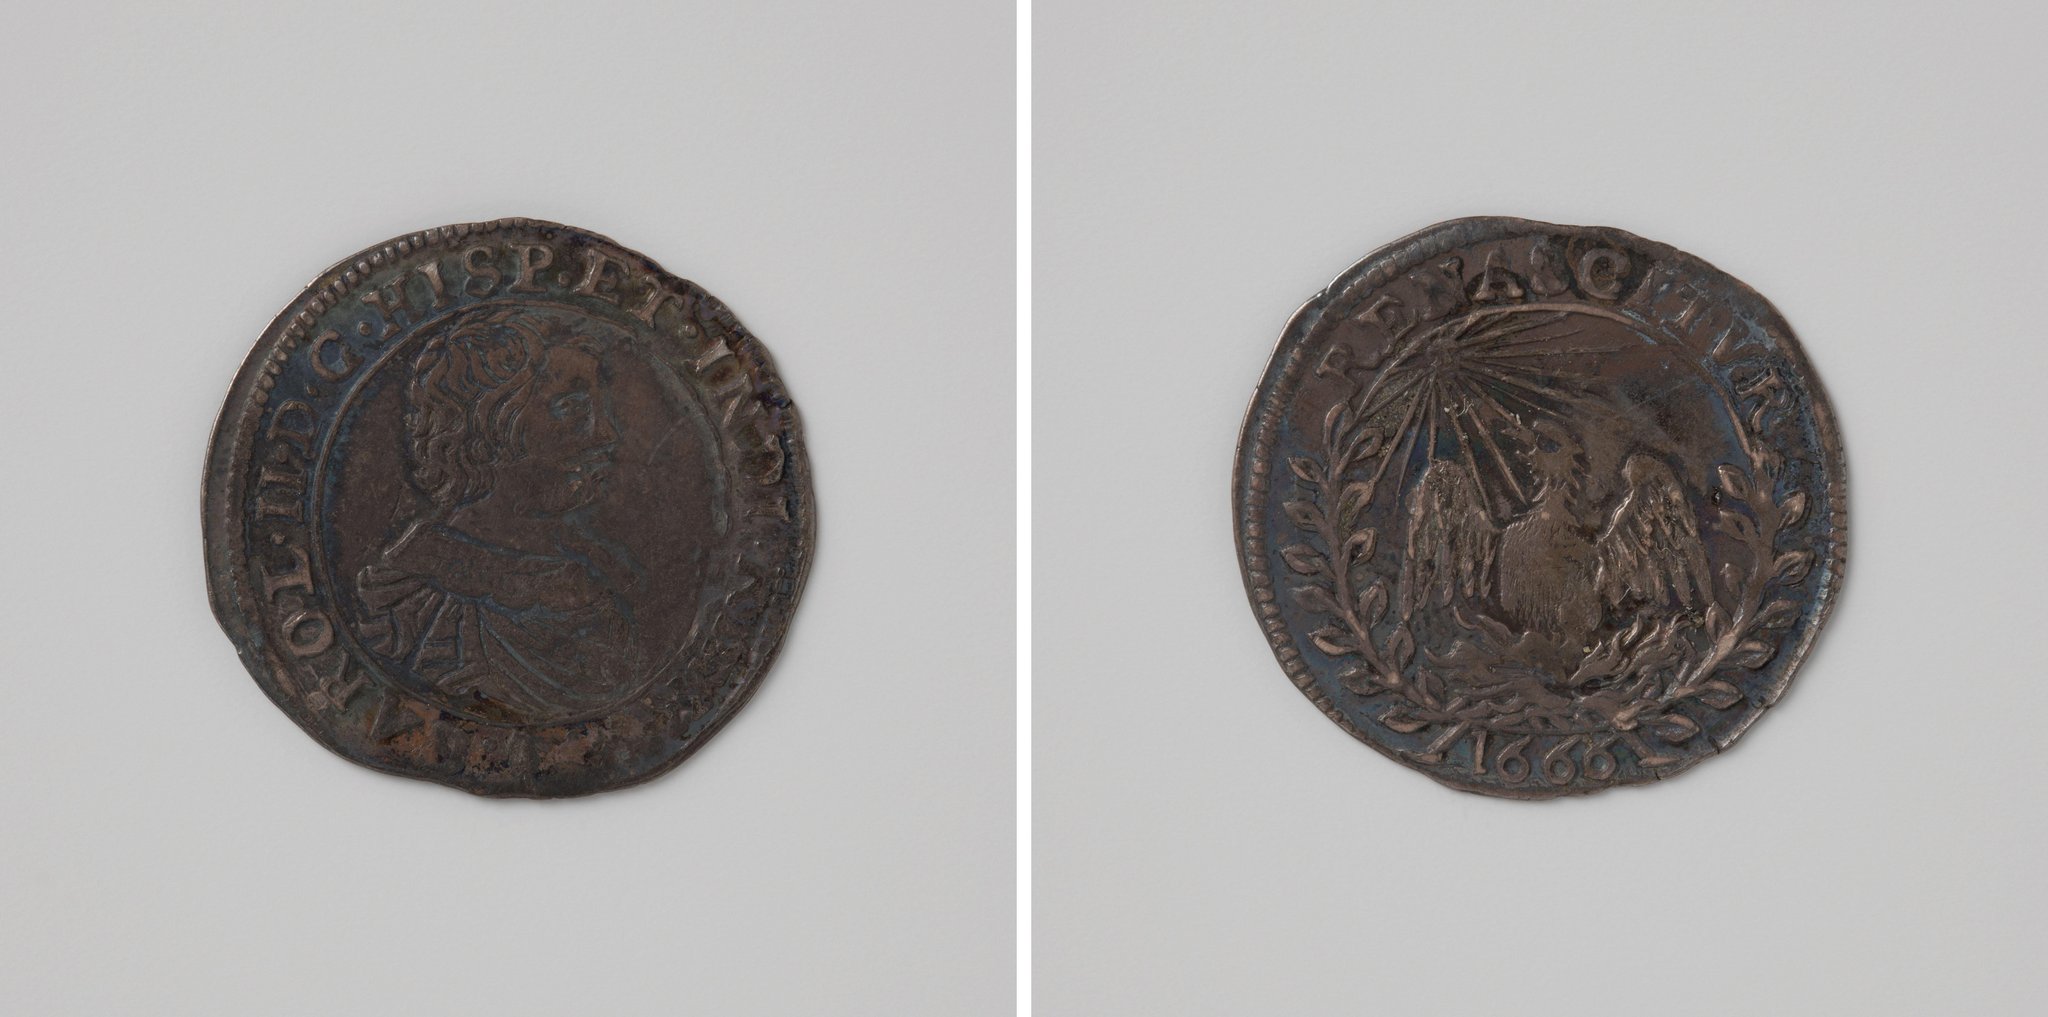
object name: strooipenning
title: Inhuldiging van Karel II van Spanje als graaf van Vlaanderen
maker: Anonymous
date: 1666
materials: silver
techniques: striking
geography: antwerp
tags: karel ii (koning van spanje)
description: Zilveren penning. Voorzijde: borststuk jongen binnen omschrift. Keerzijde: jonge phoenix oprijzend uit de vlammen binnen rand van olijftakken en omschrift